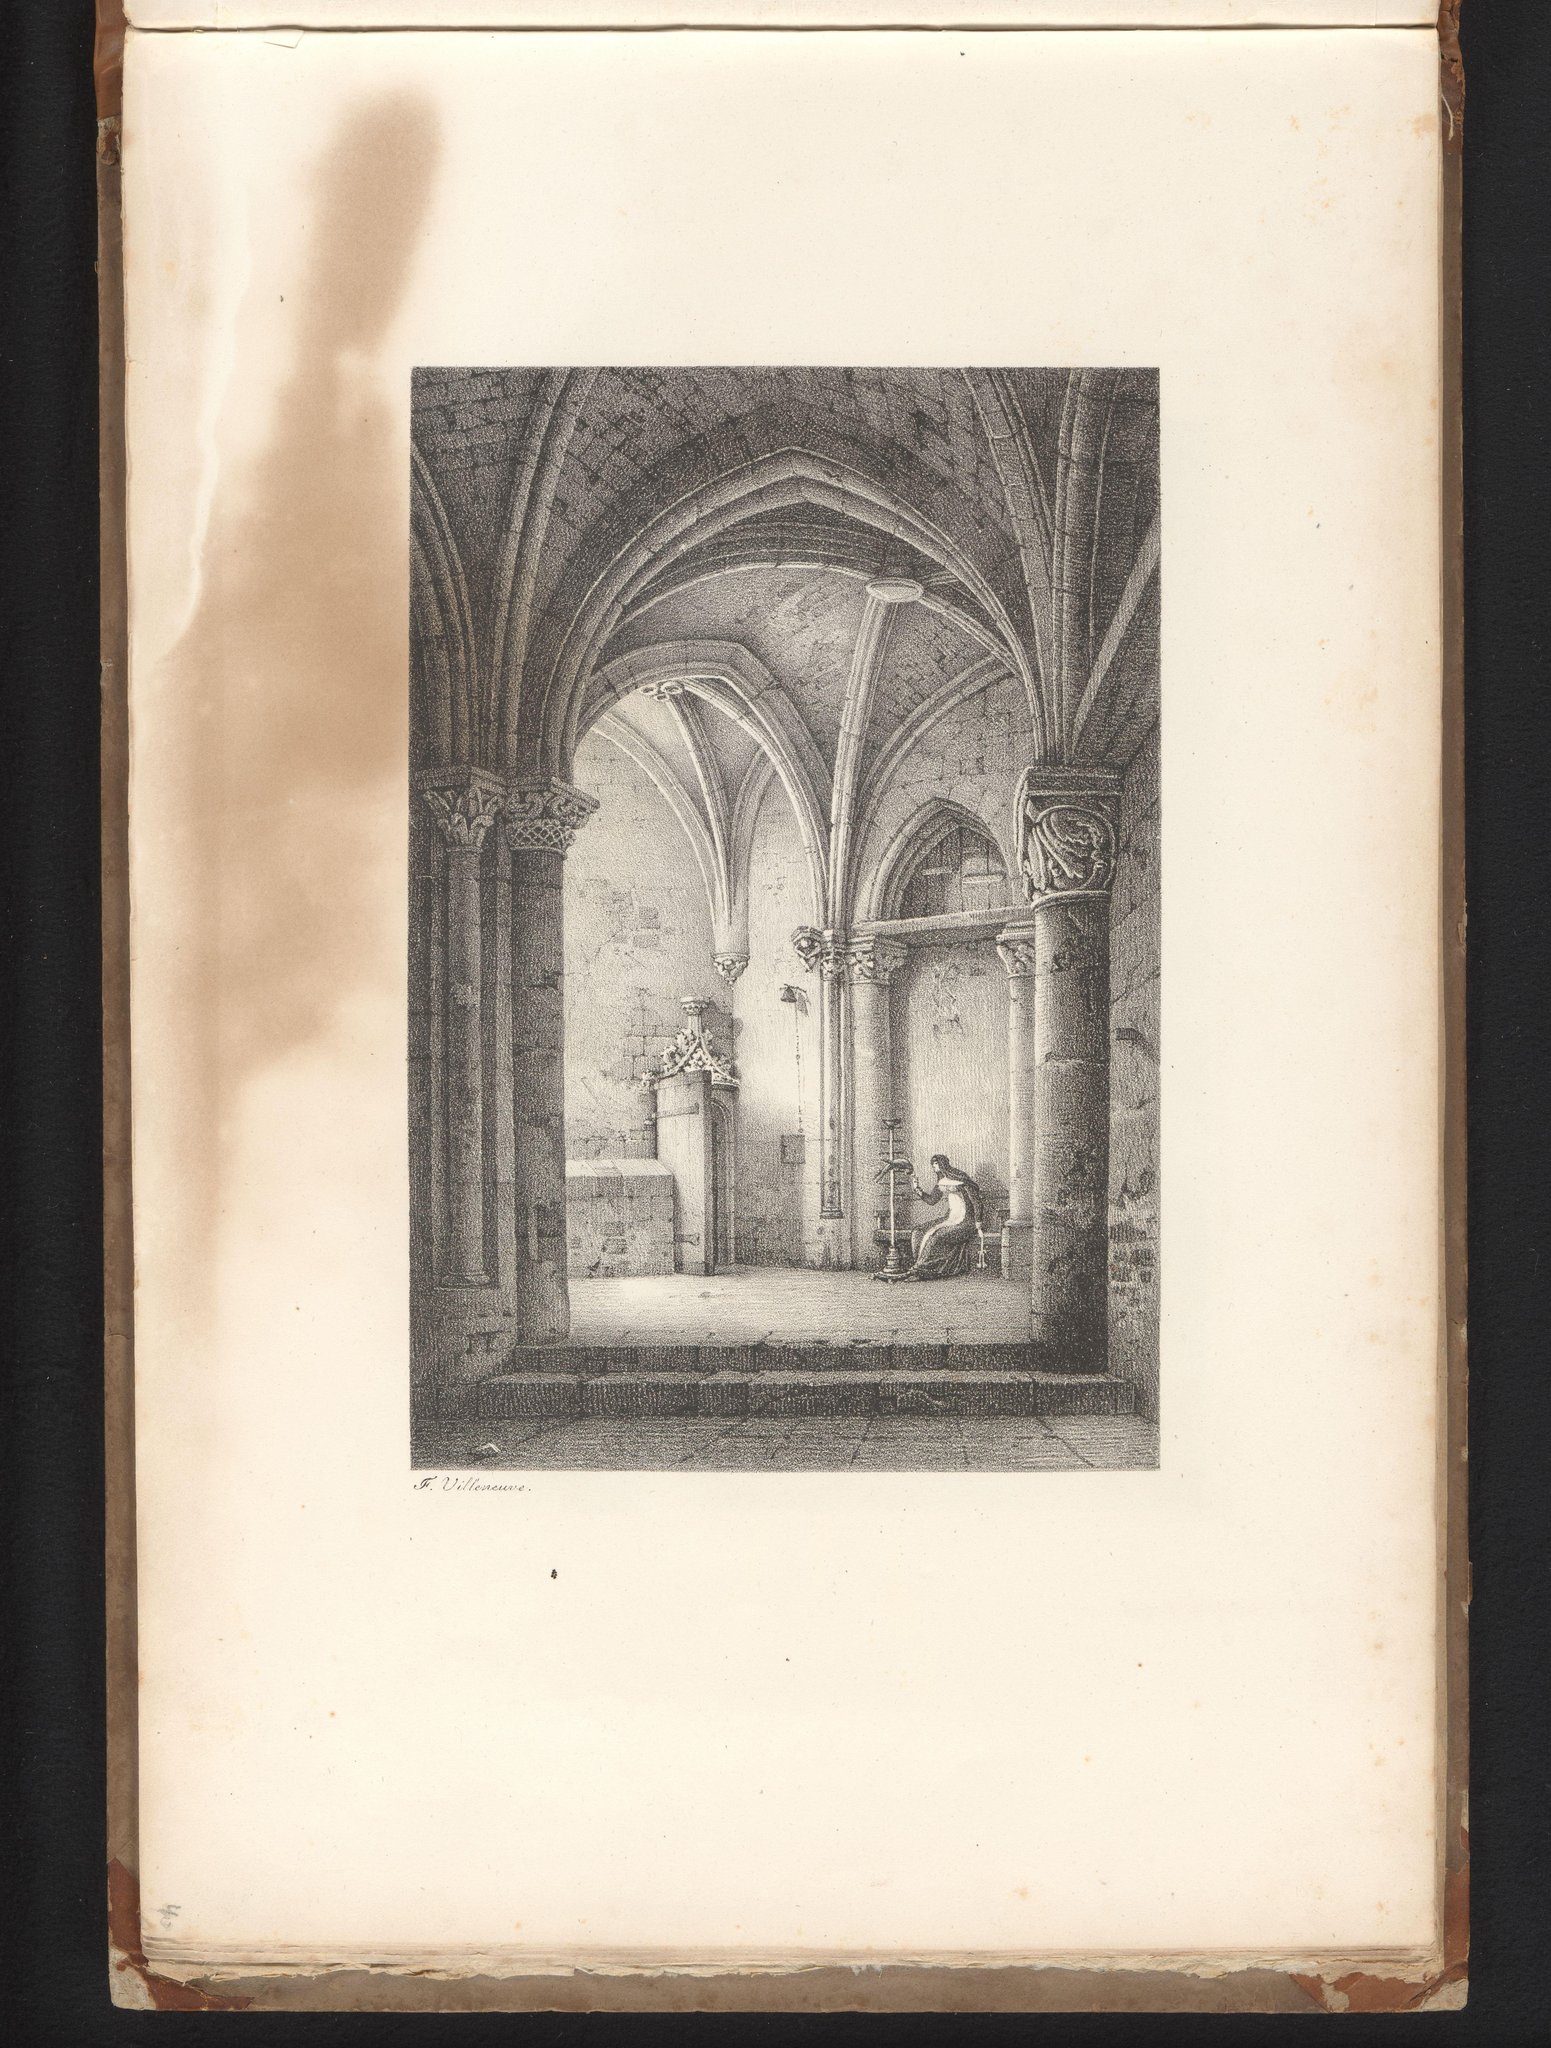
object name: print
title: Serie lithografieën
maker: louis jules fréderic villeneuve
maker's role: print maker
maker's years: 1796-1842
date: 1818-1819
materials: paper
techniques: lithograph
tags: nun(s), ornamental birds: parrot, parts of church interior: chapel